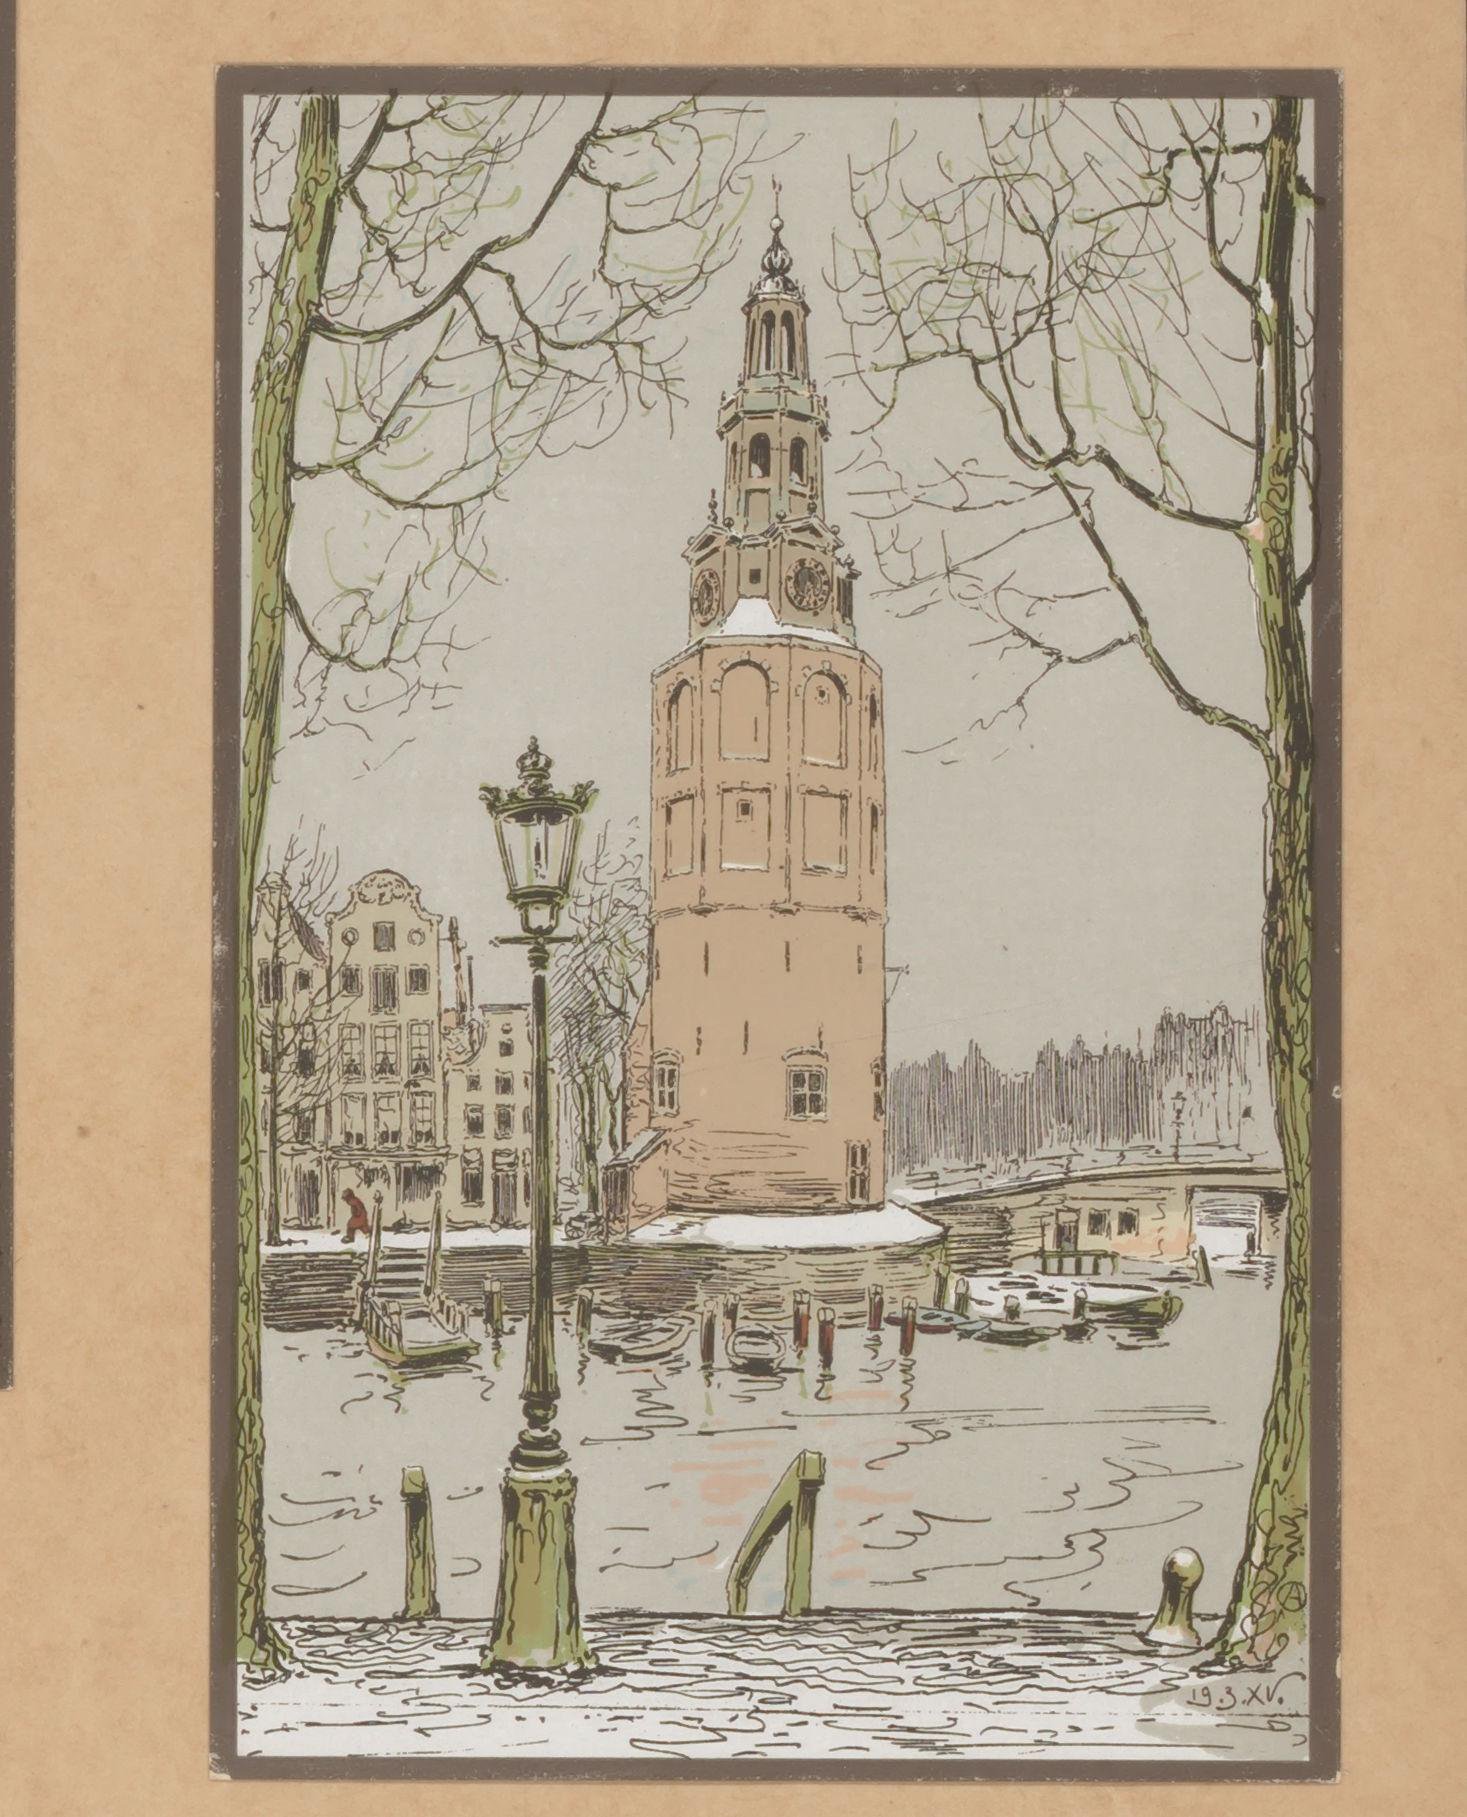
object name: ansichtkaart, prentbriefkaart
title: Gezicht op de Montelbaanstoren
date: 1915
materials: cardboard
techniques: line block, printing block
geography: utrecht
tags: tower, clock tower ~ monumental adornment, city-view in general; 'veduta', canal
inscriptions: collector's mark: ‘3-46’ Lugt 1641b, signature: ‘A’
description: Onderwerpsrubriek binnen de Atlas Amsterdam: Panorama's en verzamelprenten.